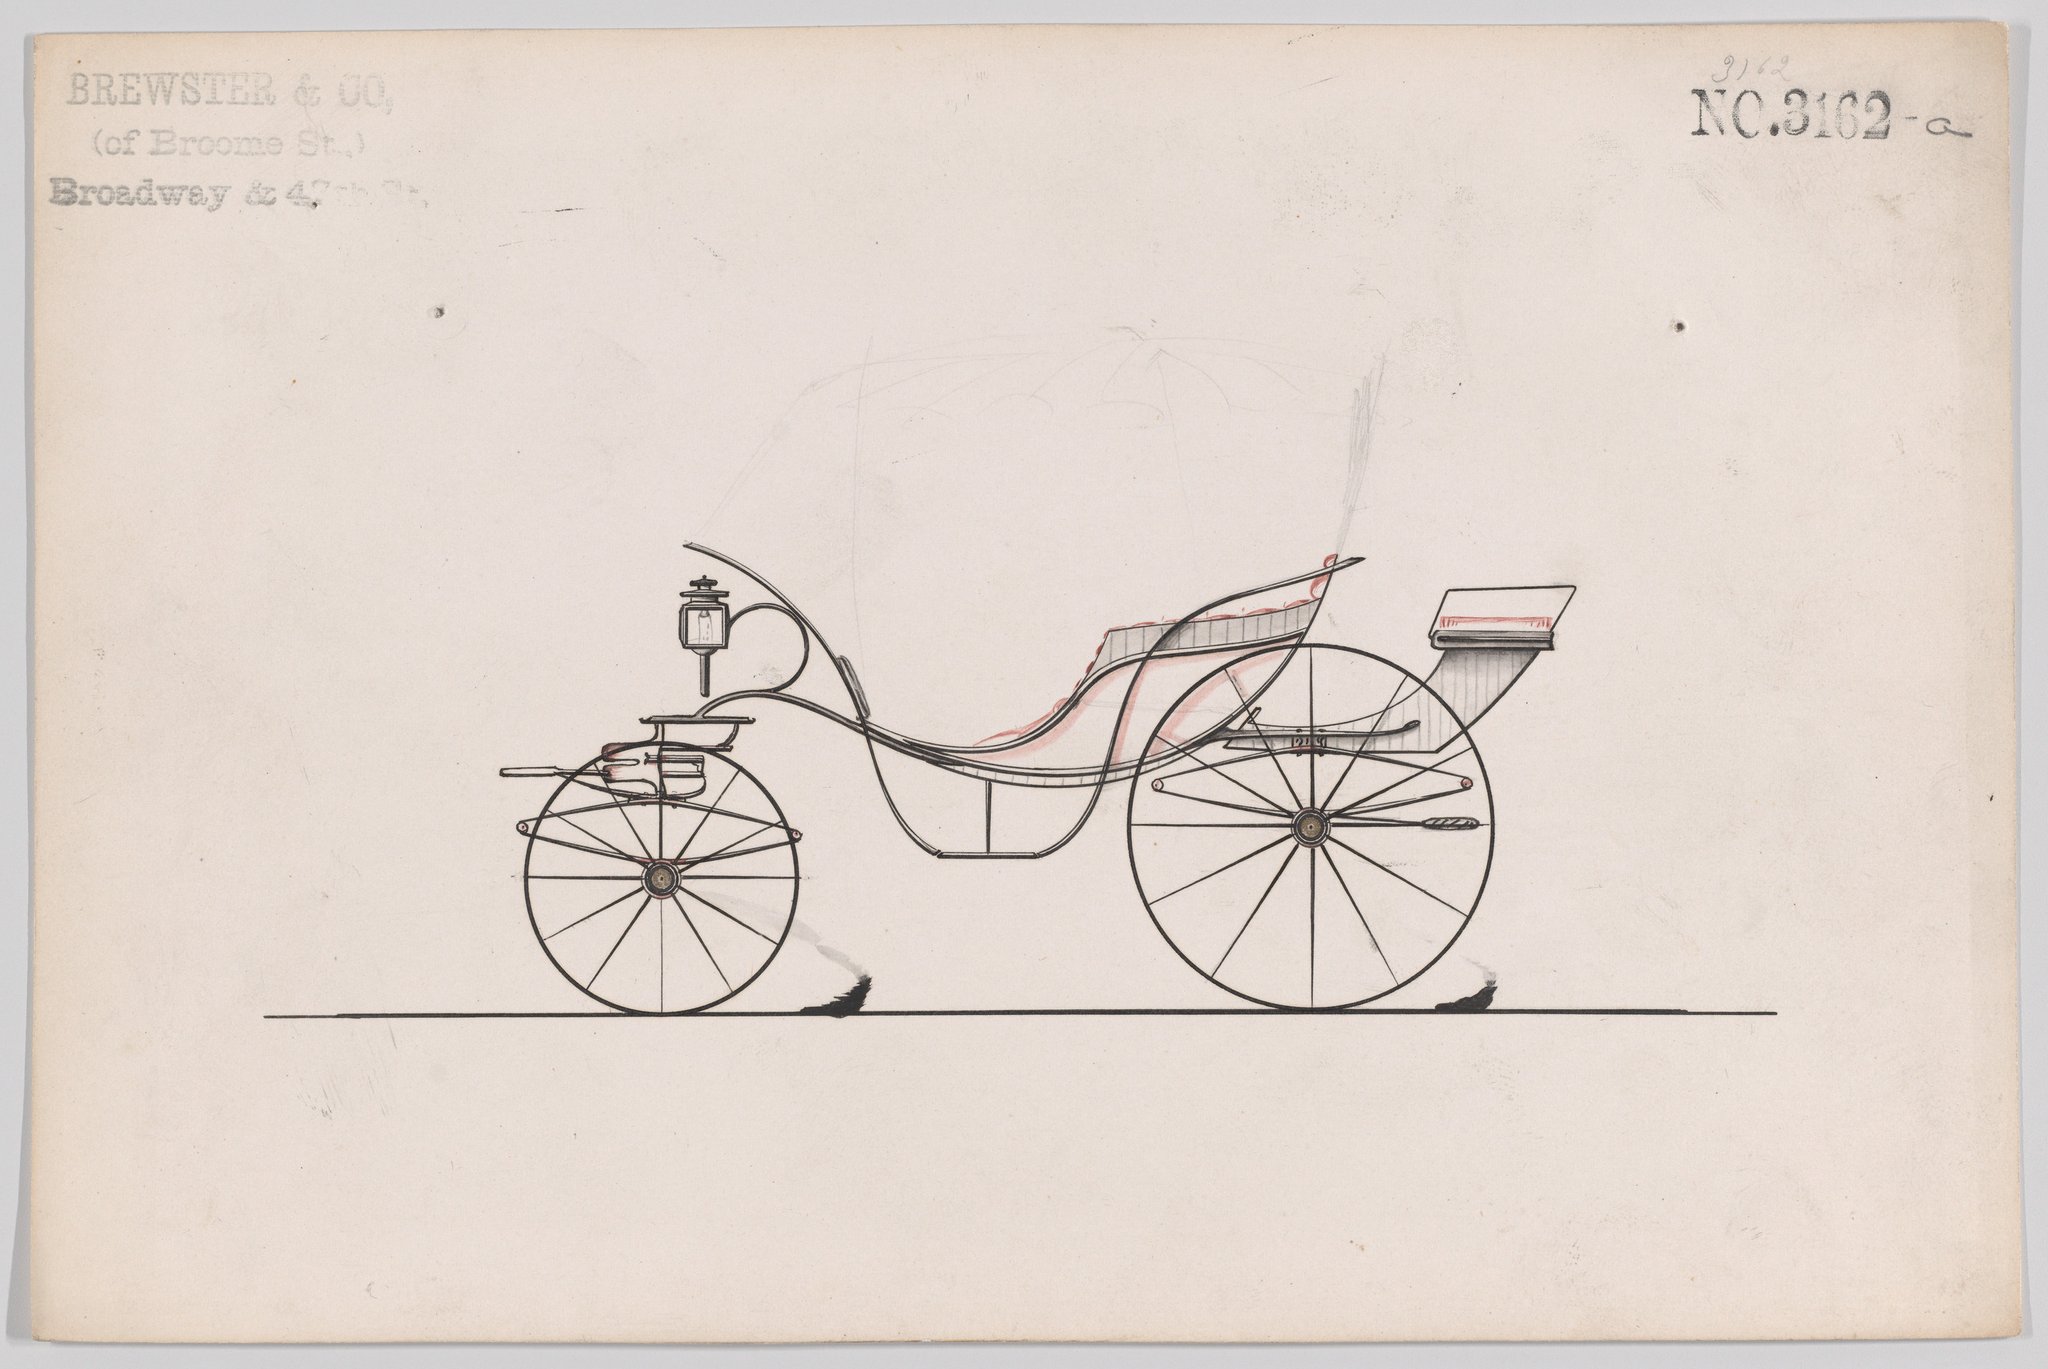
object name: drawing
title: Design for Pony Phaeton, no. 3162a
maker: brewster & co.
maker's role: manufacturer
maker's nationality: american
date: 1875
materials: gouache, graphite, ink, watercolor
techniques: pen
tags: carriages